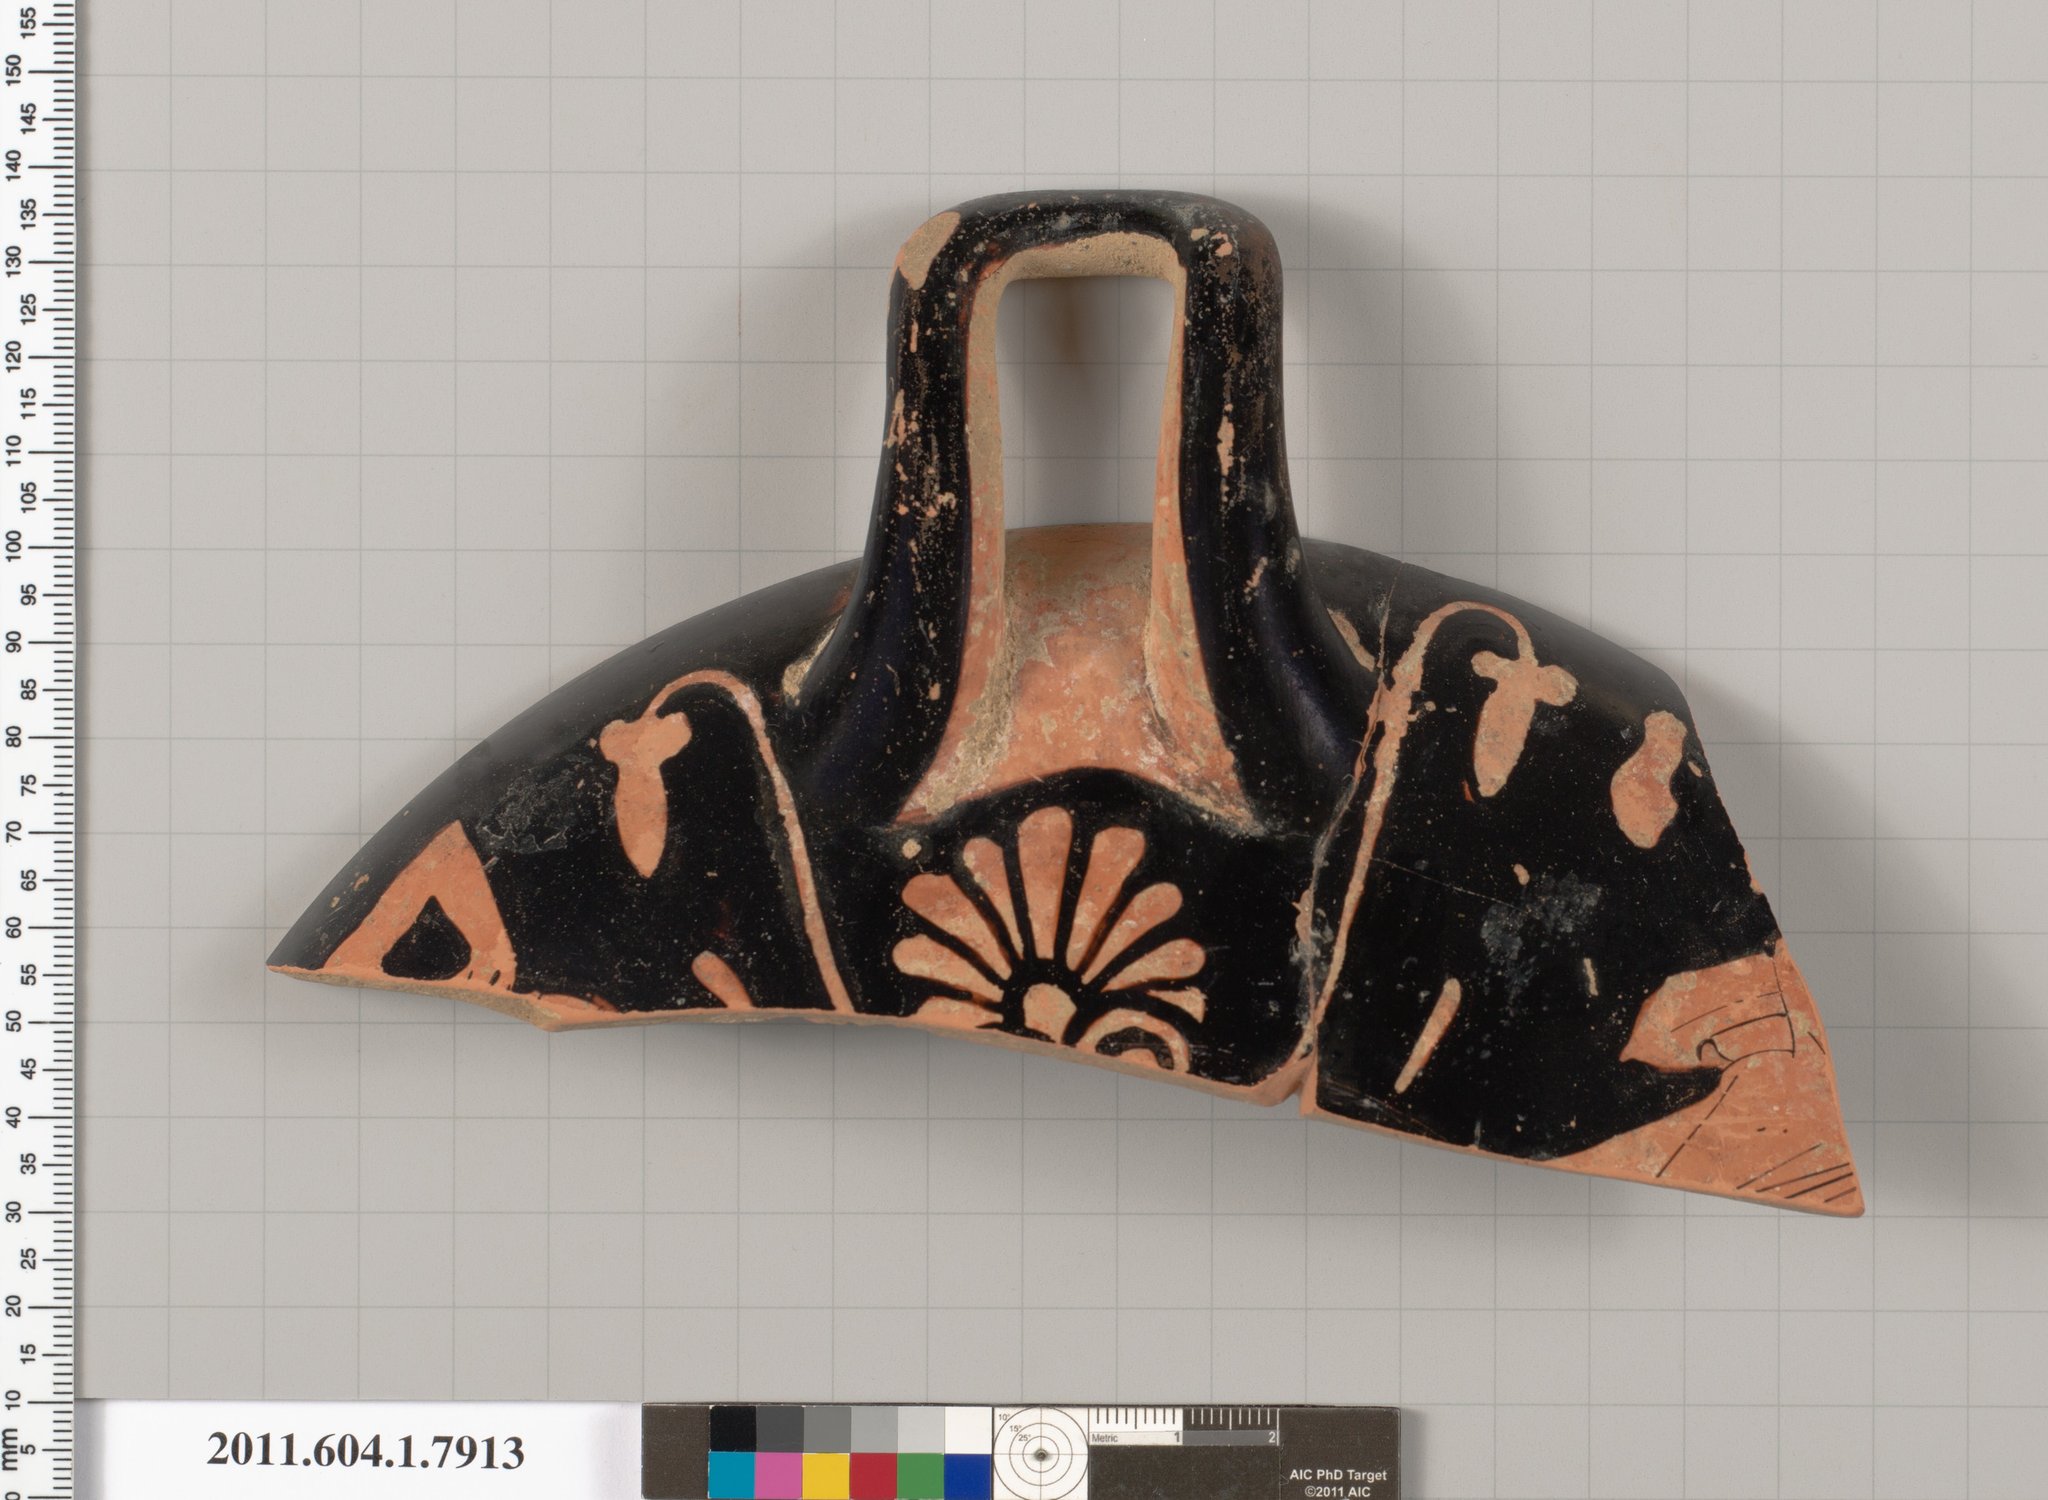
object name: kylix fragment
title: Terracotta fragment of a kylix (drinking cup)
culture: greek, attic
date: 460-450 BCE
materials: terracotta